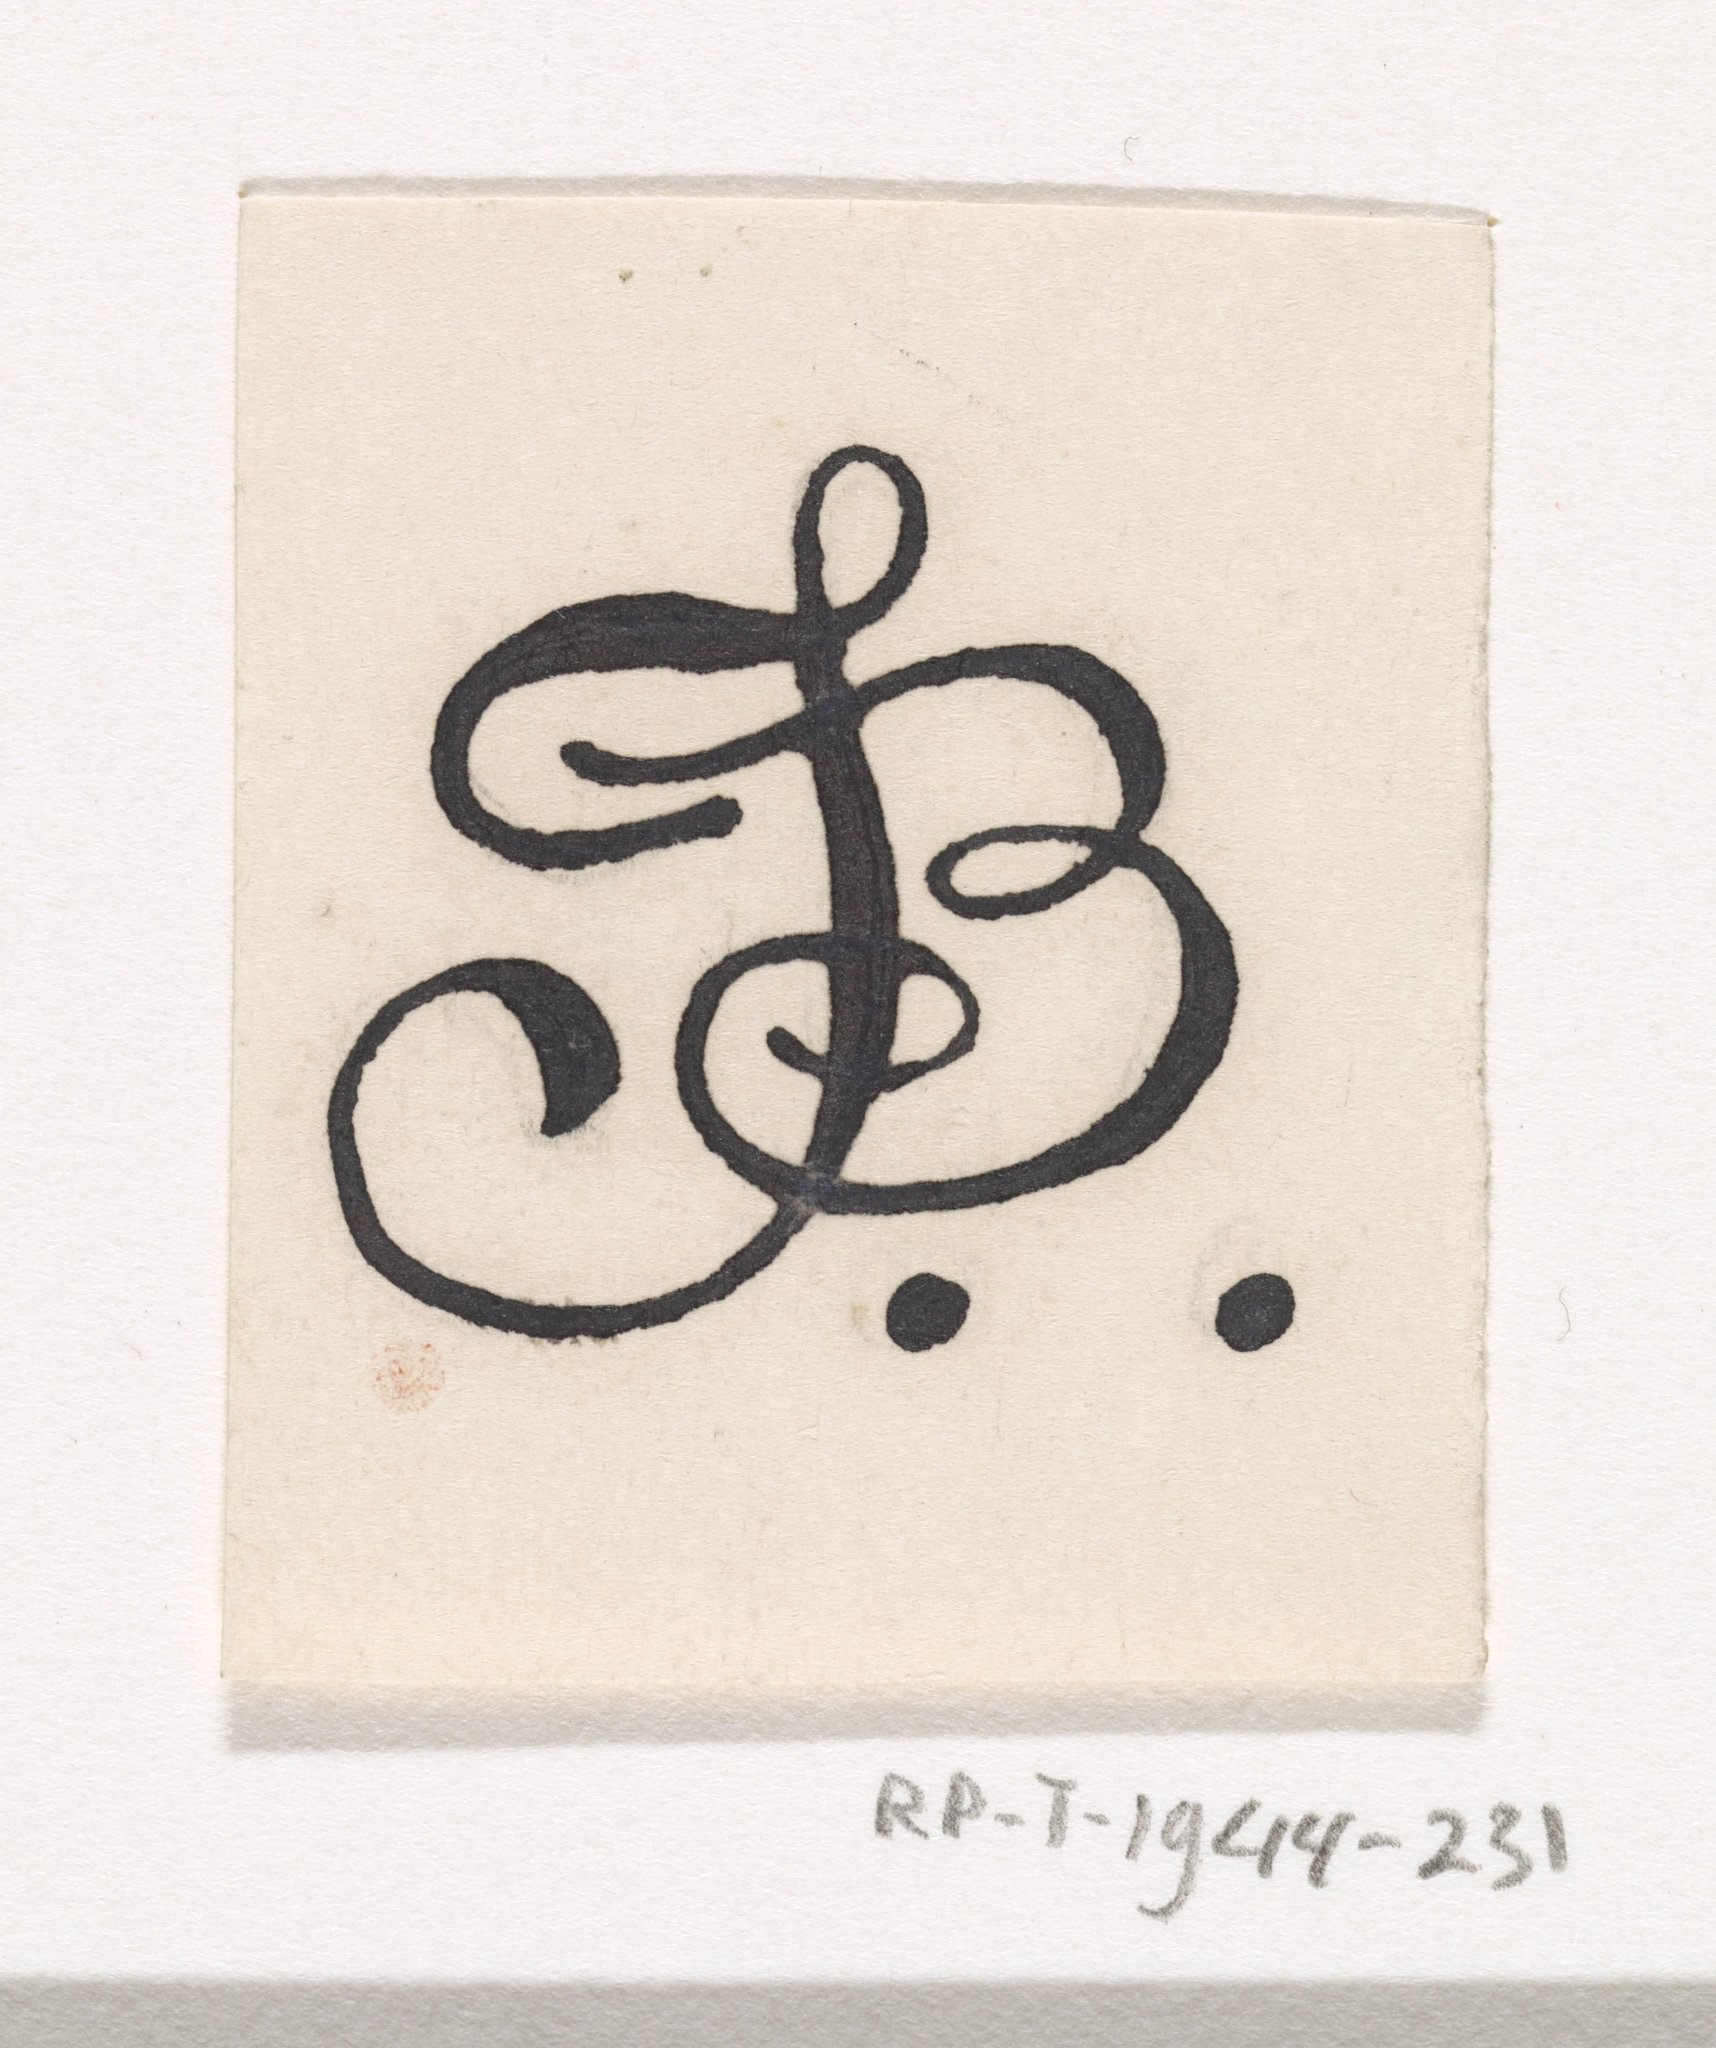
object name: drawing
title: Ontwerp voor een monogram met de letters J en B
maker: antoon derkinderen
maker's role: draughtsman, painter, print maker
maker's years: 1859-1925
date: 1869-1925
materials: ink, paper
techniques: pen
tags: letter combinations such as letterword, anagram, letter square, monogram, etc.